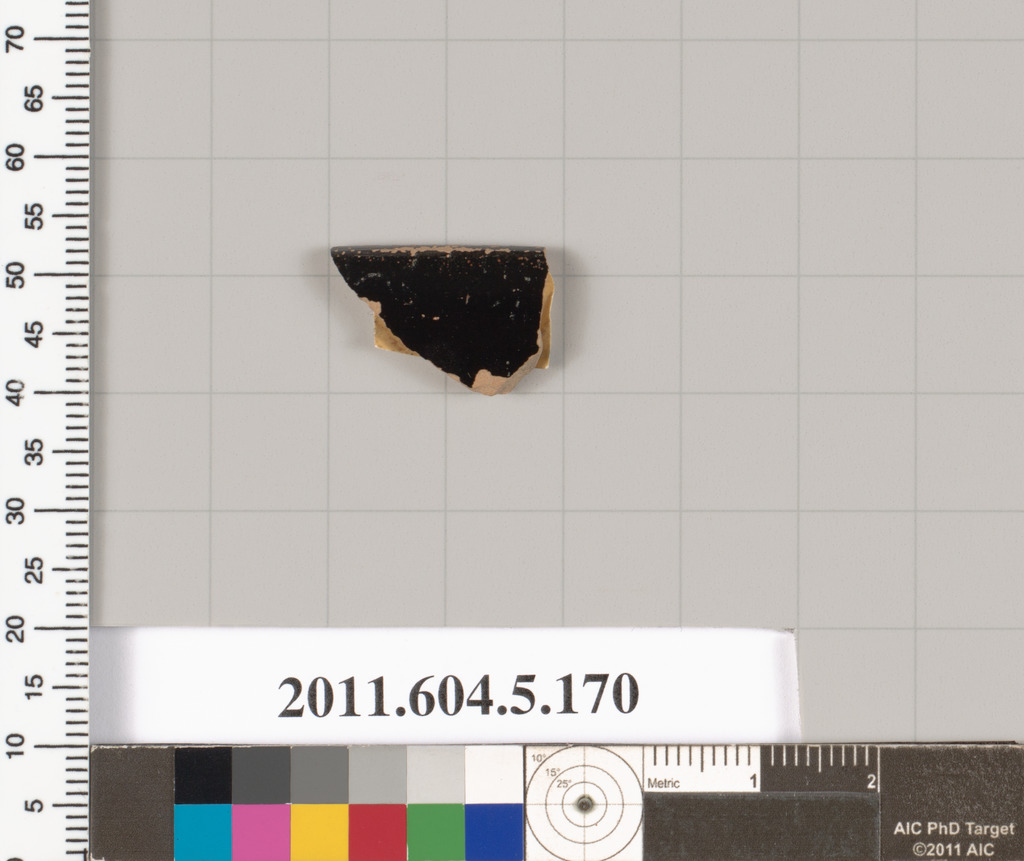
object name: kylix fragment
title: Terracotta rim fragment of a kylix (drinking cup)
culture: greek, attic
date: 600-401 BCE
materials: terracotta